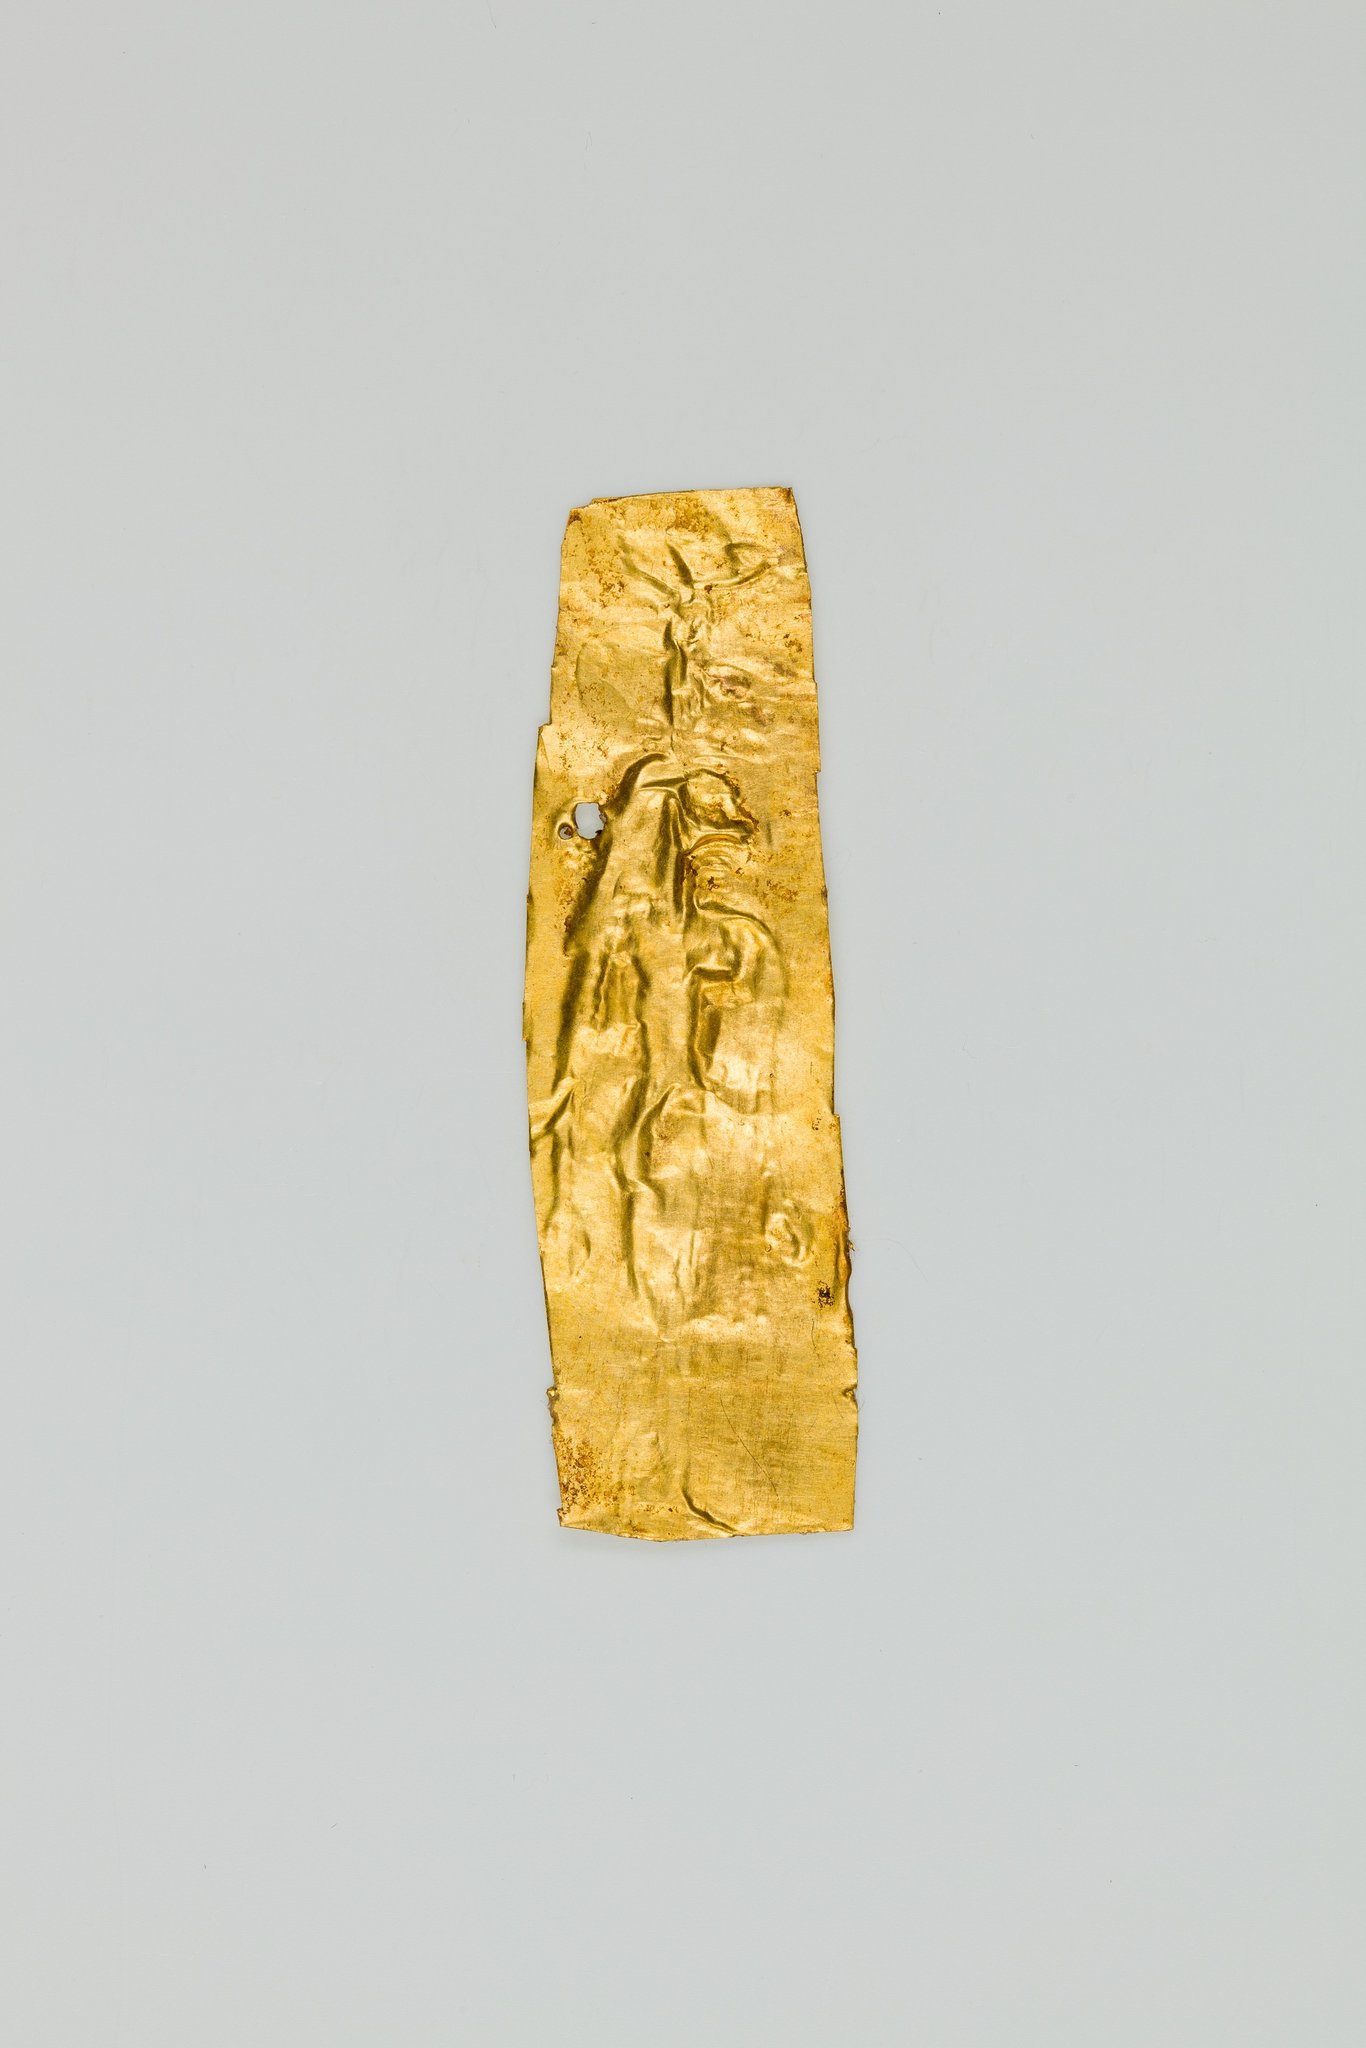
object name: amulet, nephthys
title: Nephthys amulet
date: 664-380 BCE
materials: gold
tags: goddess